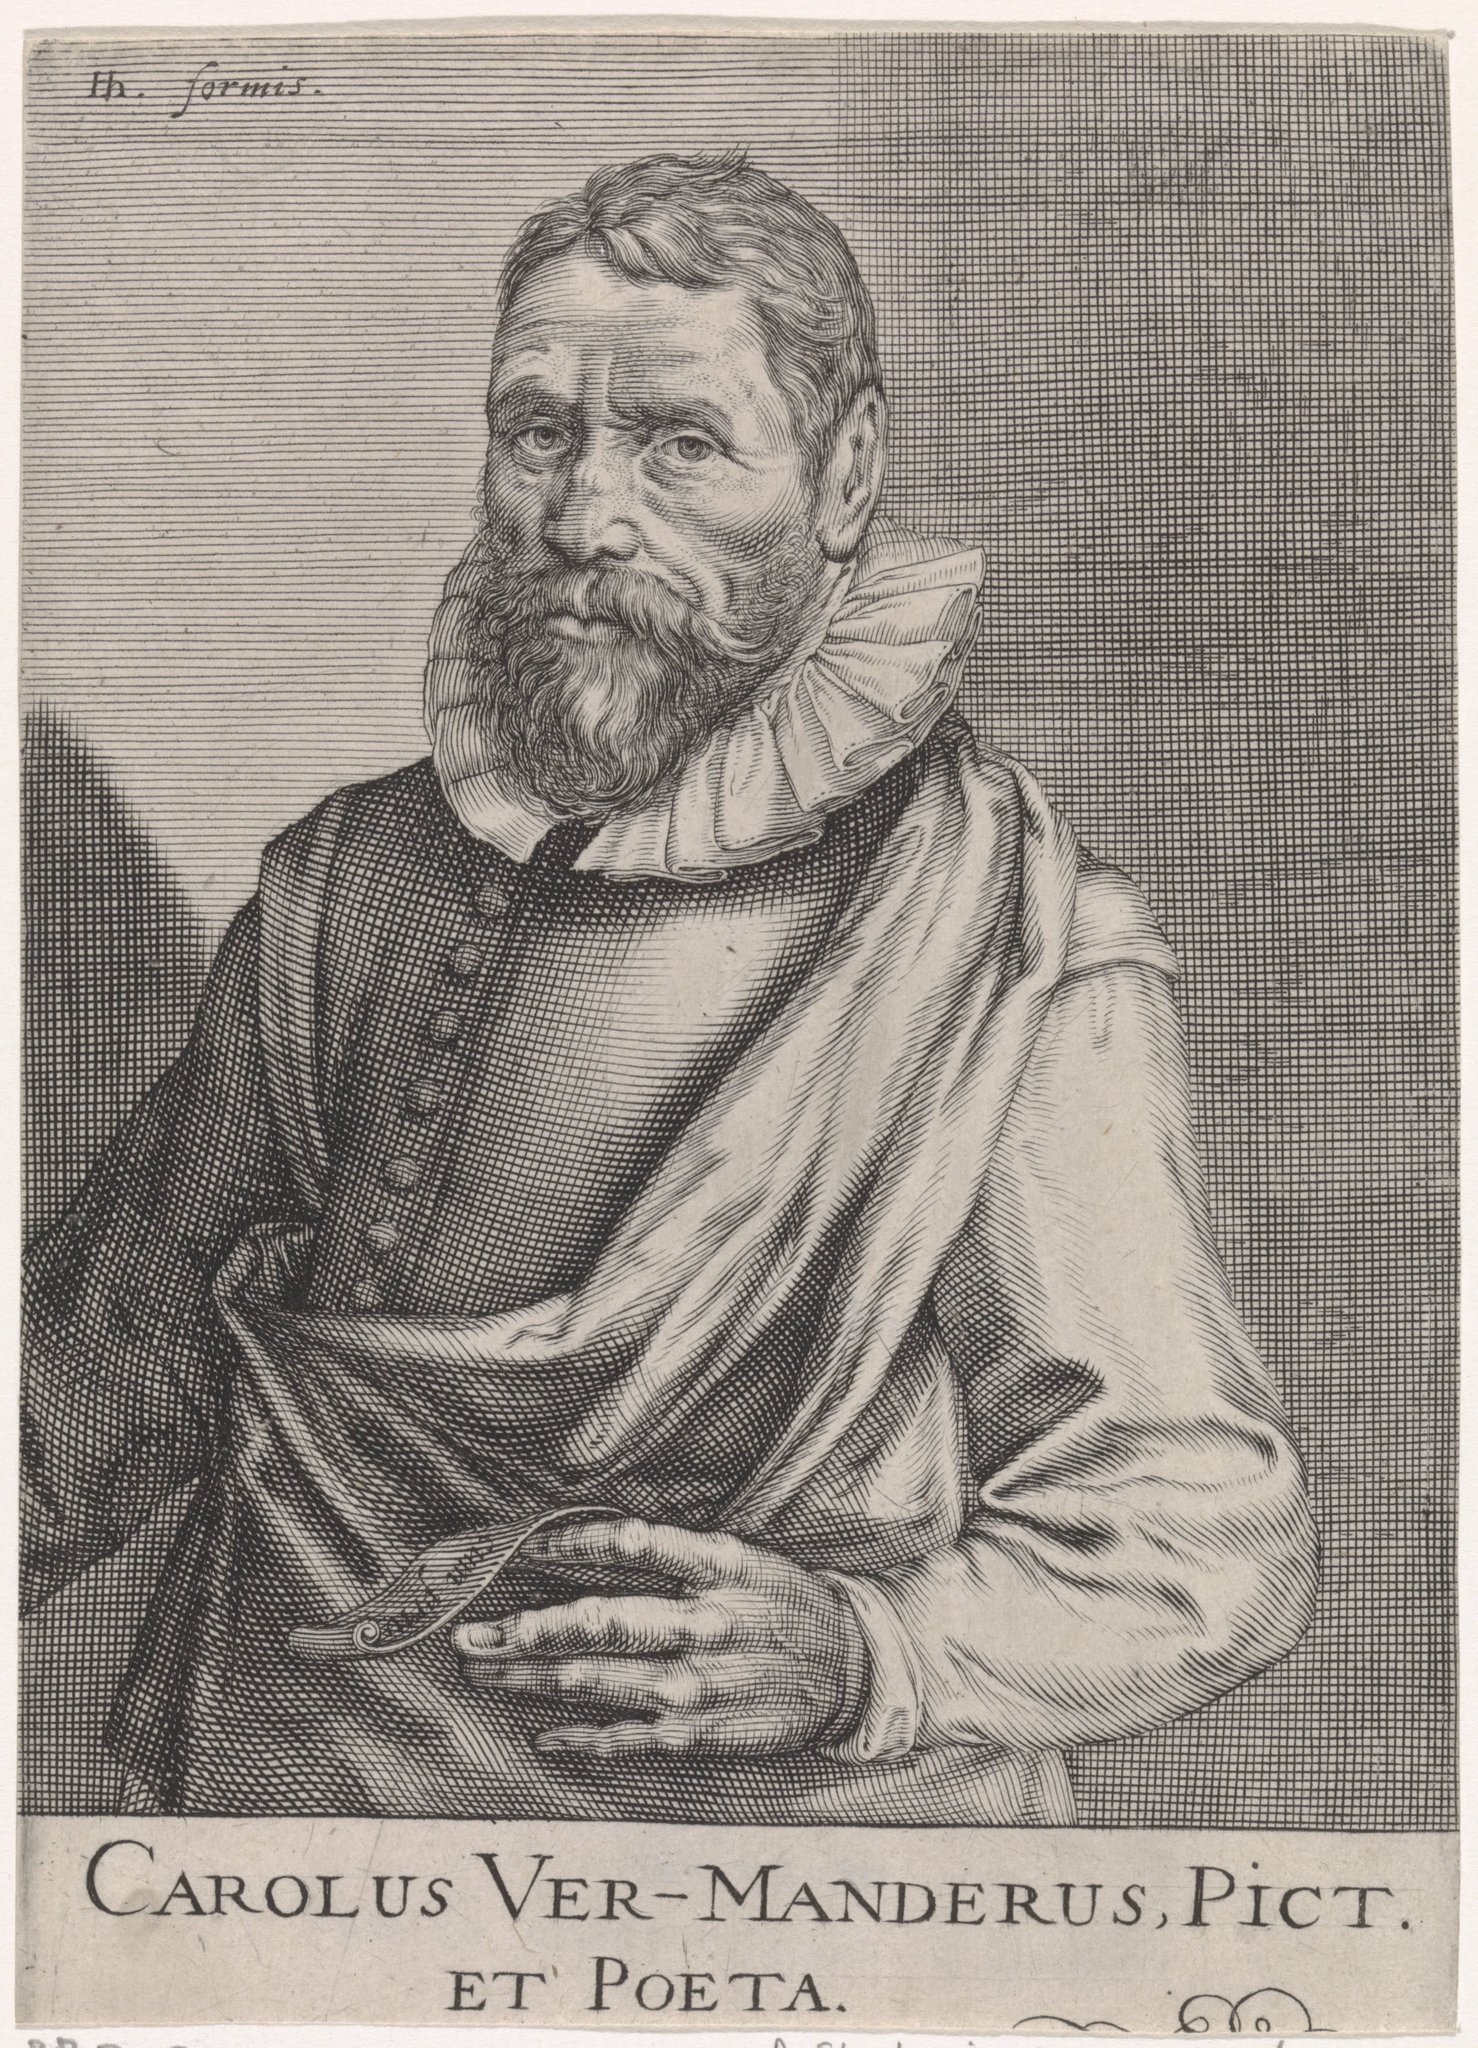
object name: print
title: Portretten van beroemde schilders uit de Lage Landen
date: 1610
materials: paper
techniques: engraving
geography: the hague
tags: painter, draughtsman, karel van mander (i), portrait, self-portrait of painter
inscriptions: collector's mark: Lugt 2228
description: Portret ten halven lijve naar links van Karel van Mander. Onder het portret zijn naam in het Latijn. Prent uit deel 2 van de serie Pictorum Aliquot Celebrium Praecipuae Germaniae Inferioris Effigies. Serie van 72 kunstenaarsportretten vervaardigd door Hendrick Hondius I, Simon Frisius, Andries Jacobsz. Stock en Robert de Baudous.